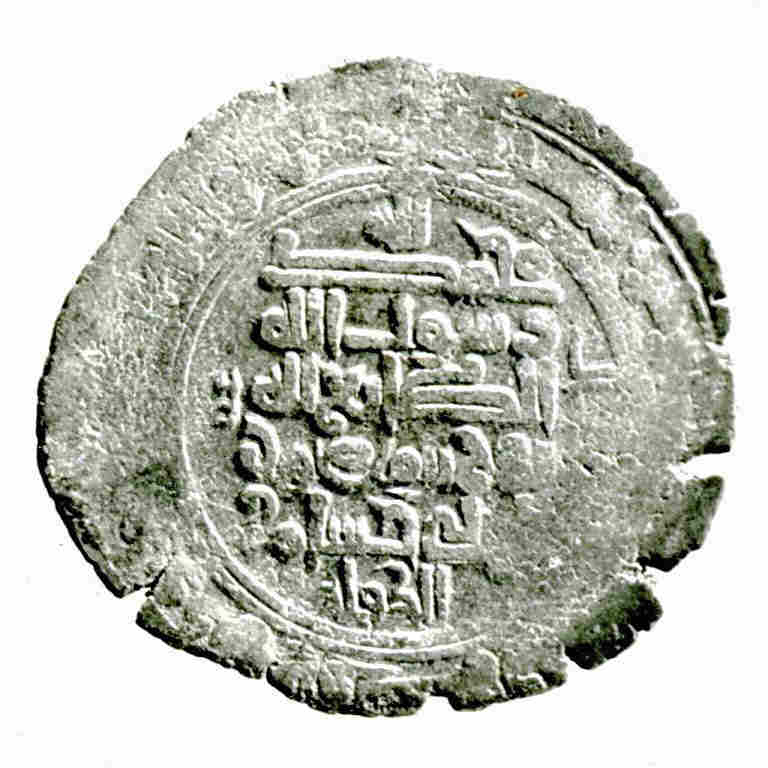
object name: coin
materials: silver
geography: iran